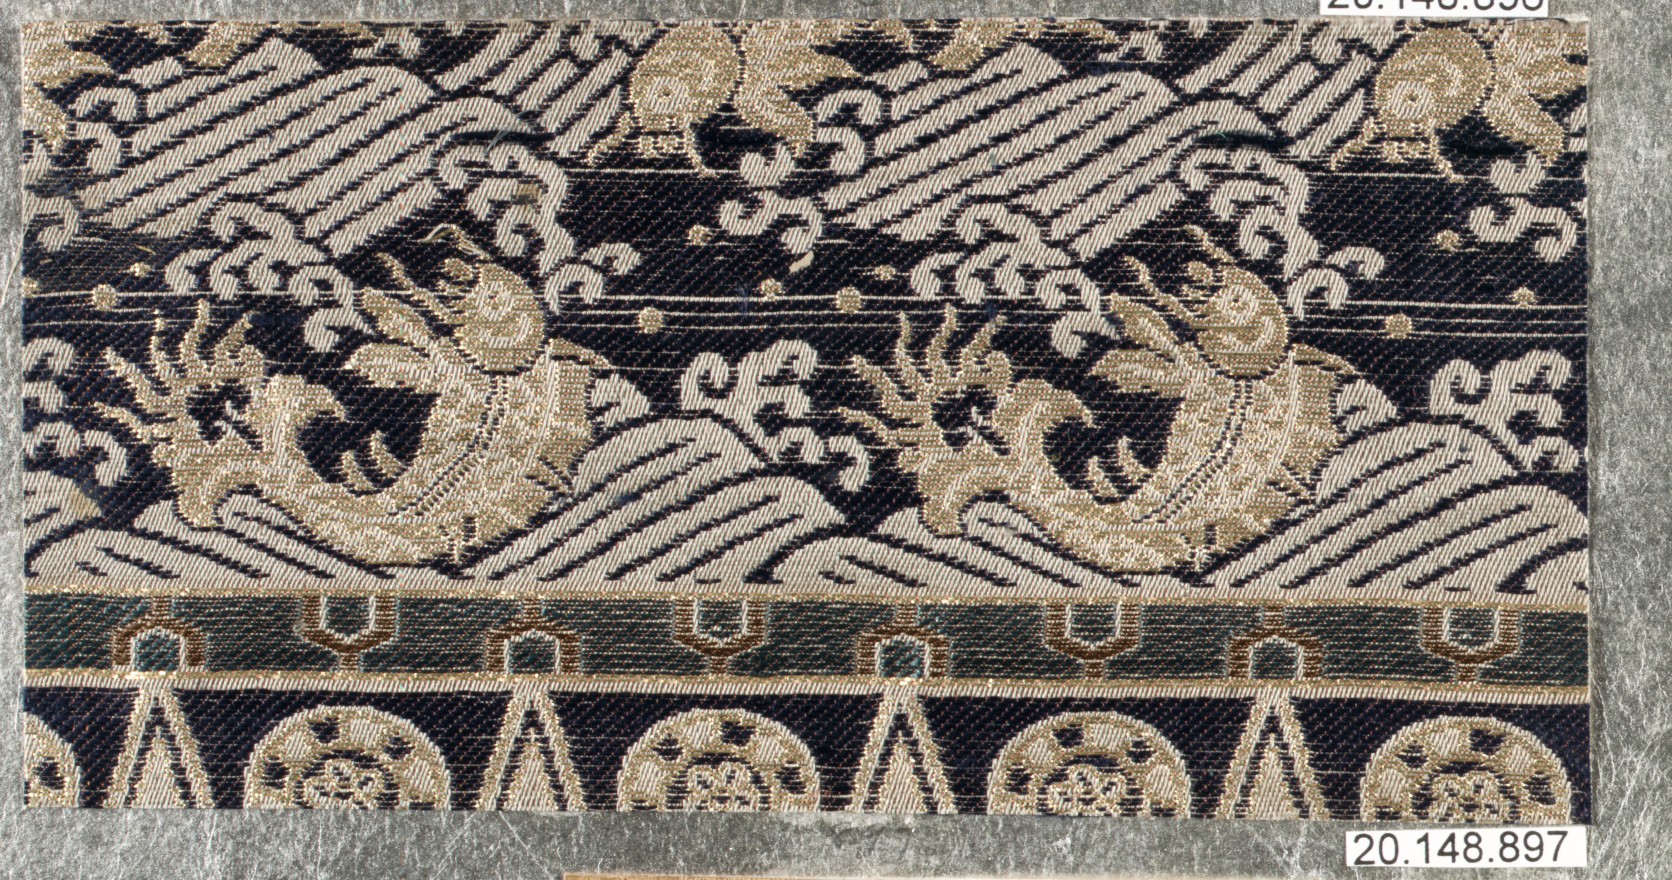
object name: textile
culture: china or japan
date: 1701-1800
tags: fish,waves